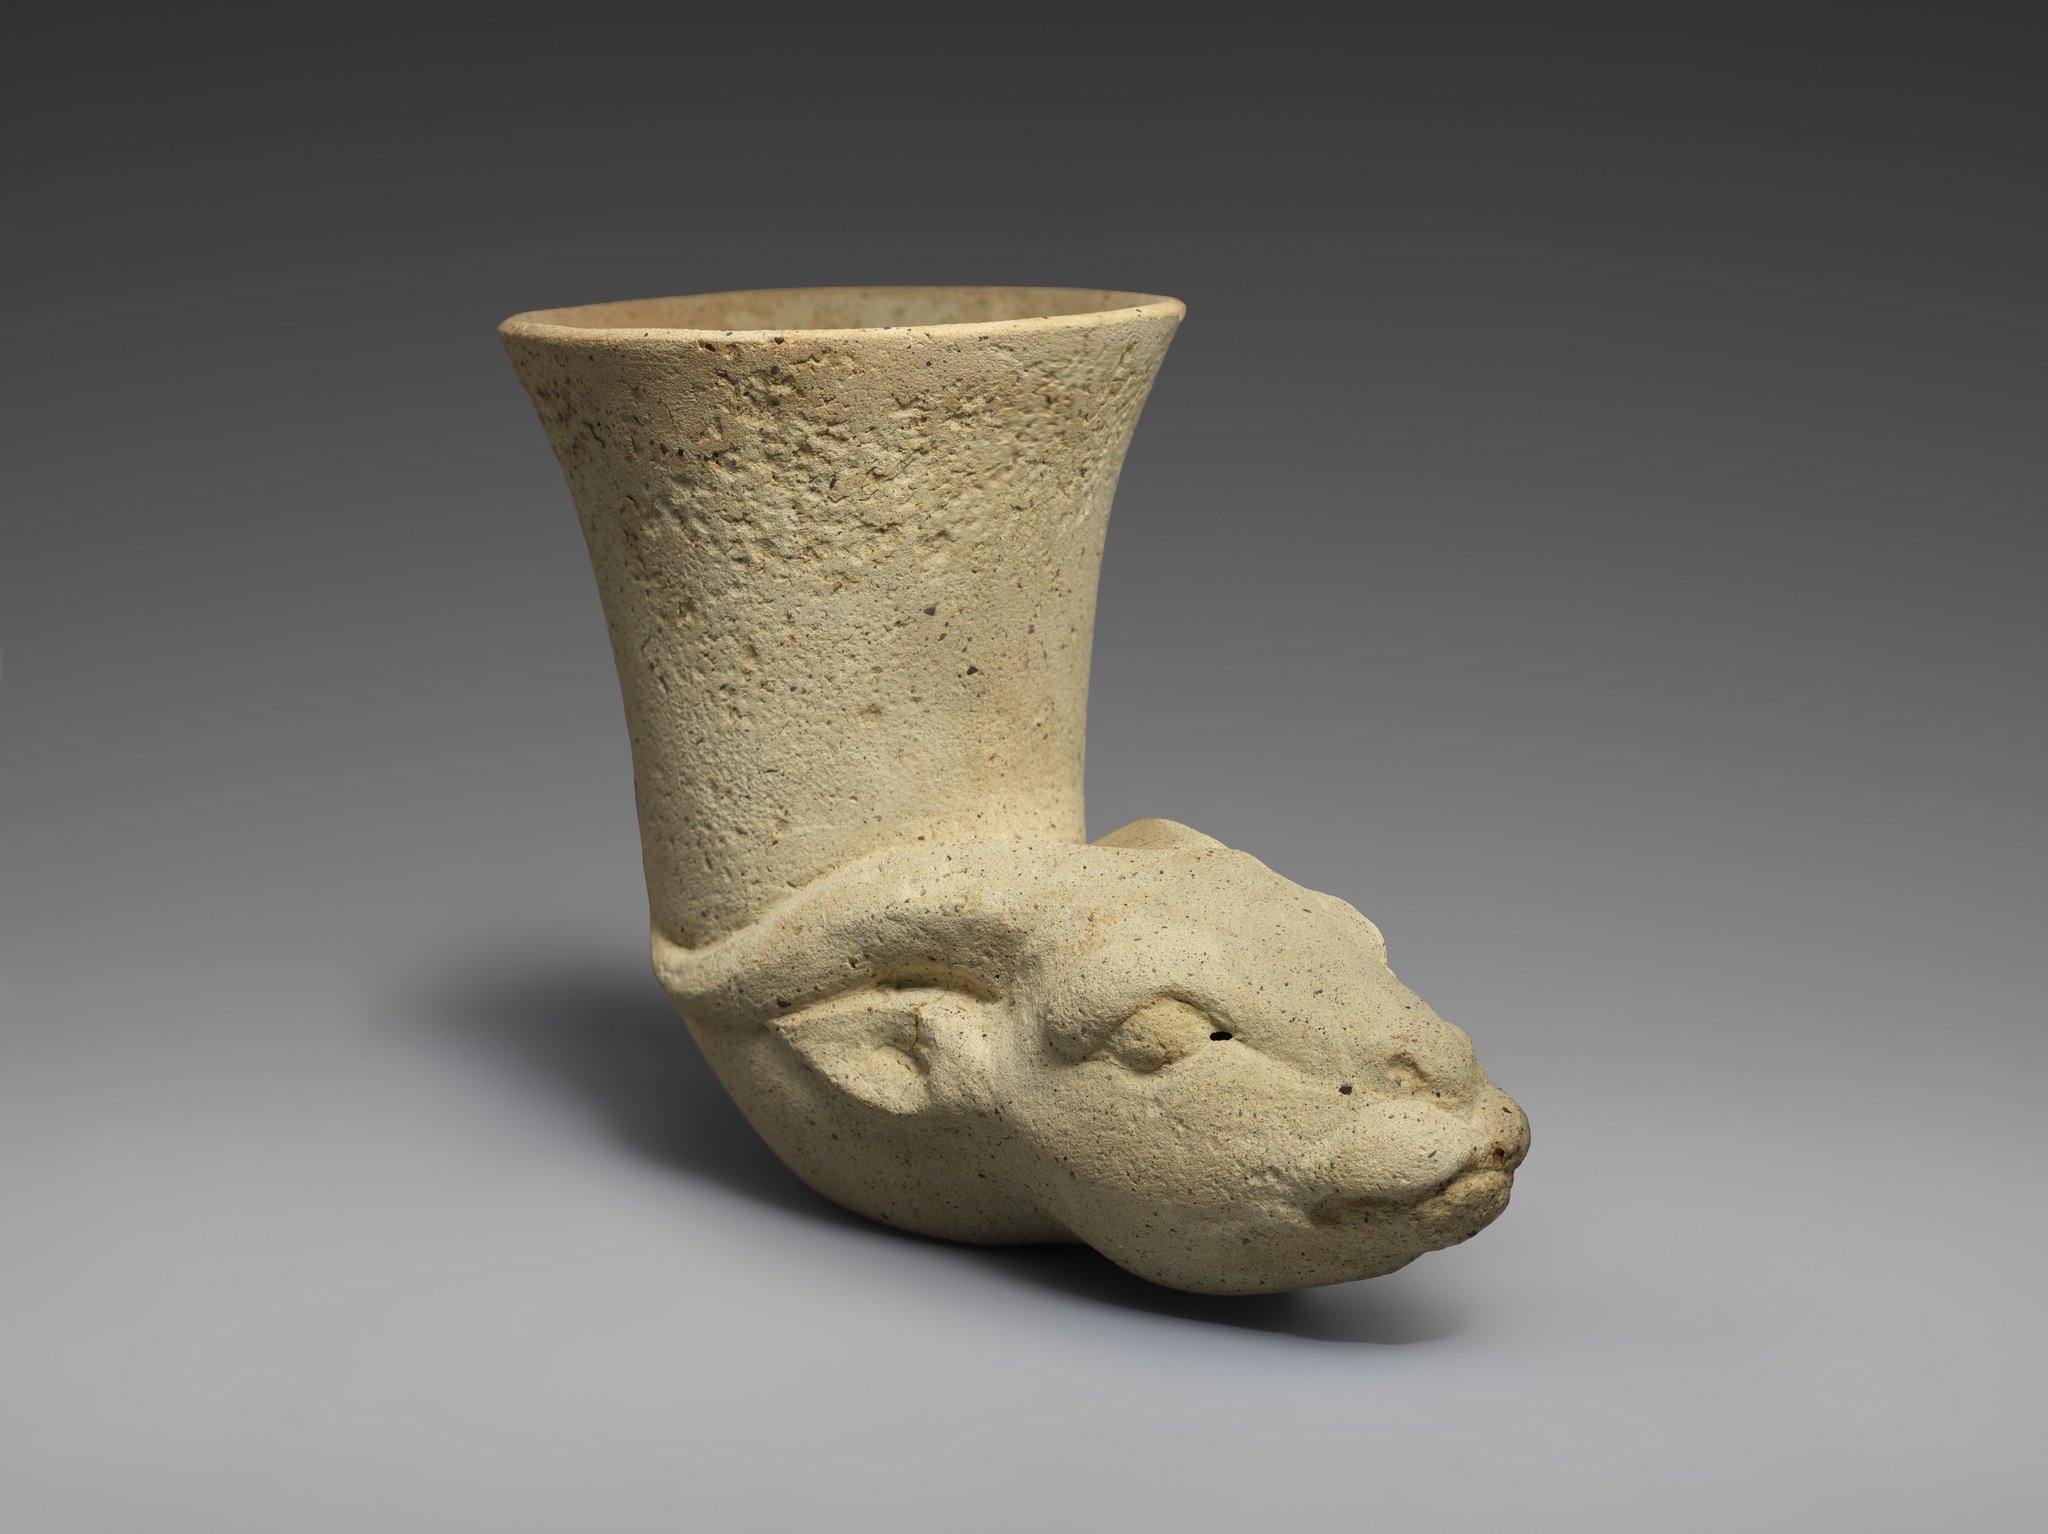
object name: vessel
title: Vessel terminating in the head of an antelope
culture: iranian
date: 700-601 BCE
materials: ceramic, glaze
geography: iran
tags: animals